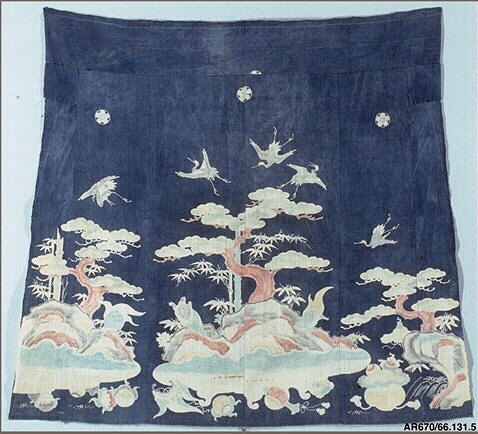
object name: panel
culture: japanese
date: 1801-1833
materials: bamboo, cotton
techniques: dyeing, painting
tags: trees